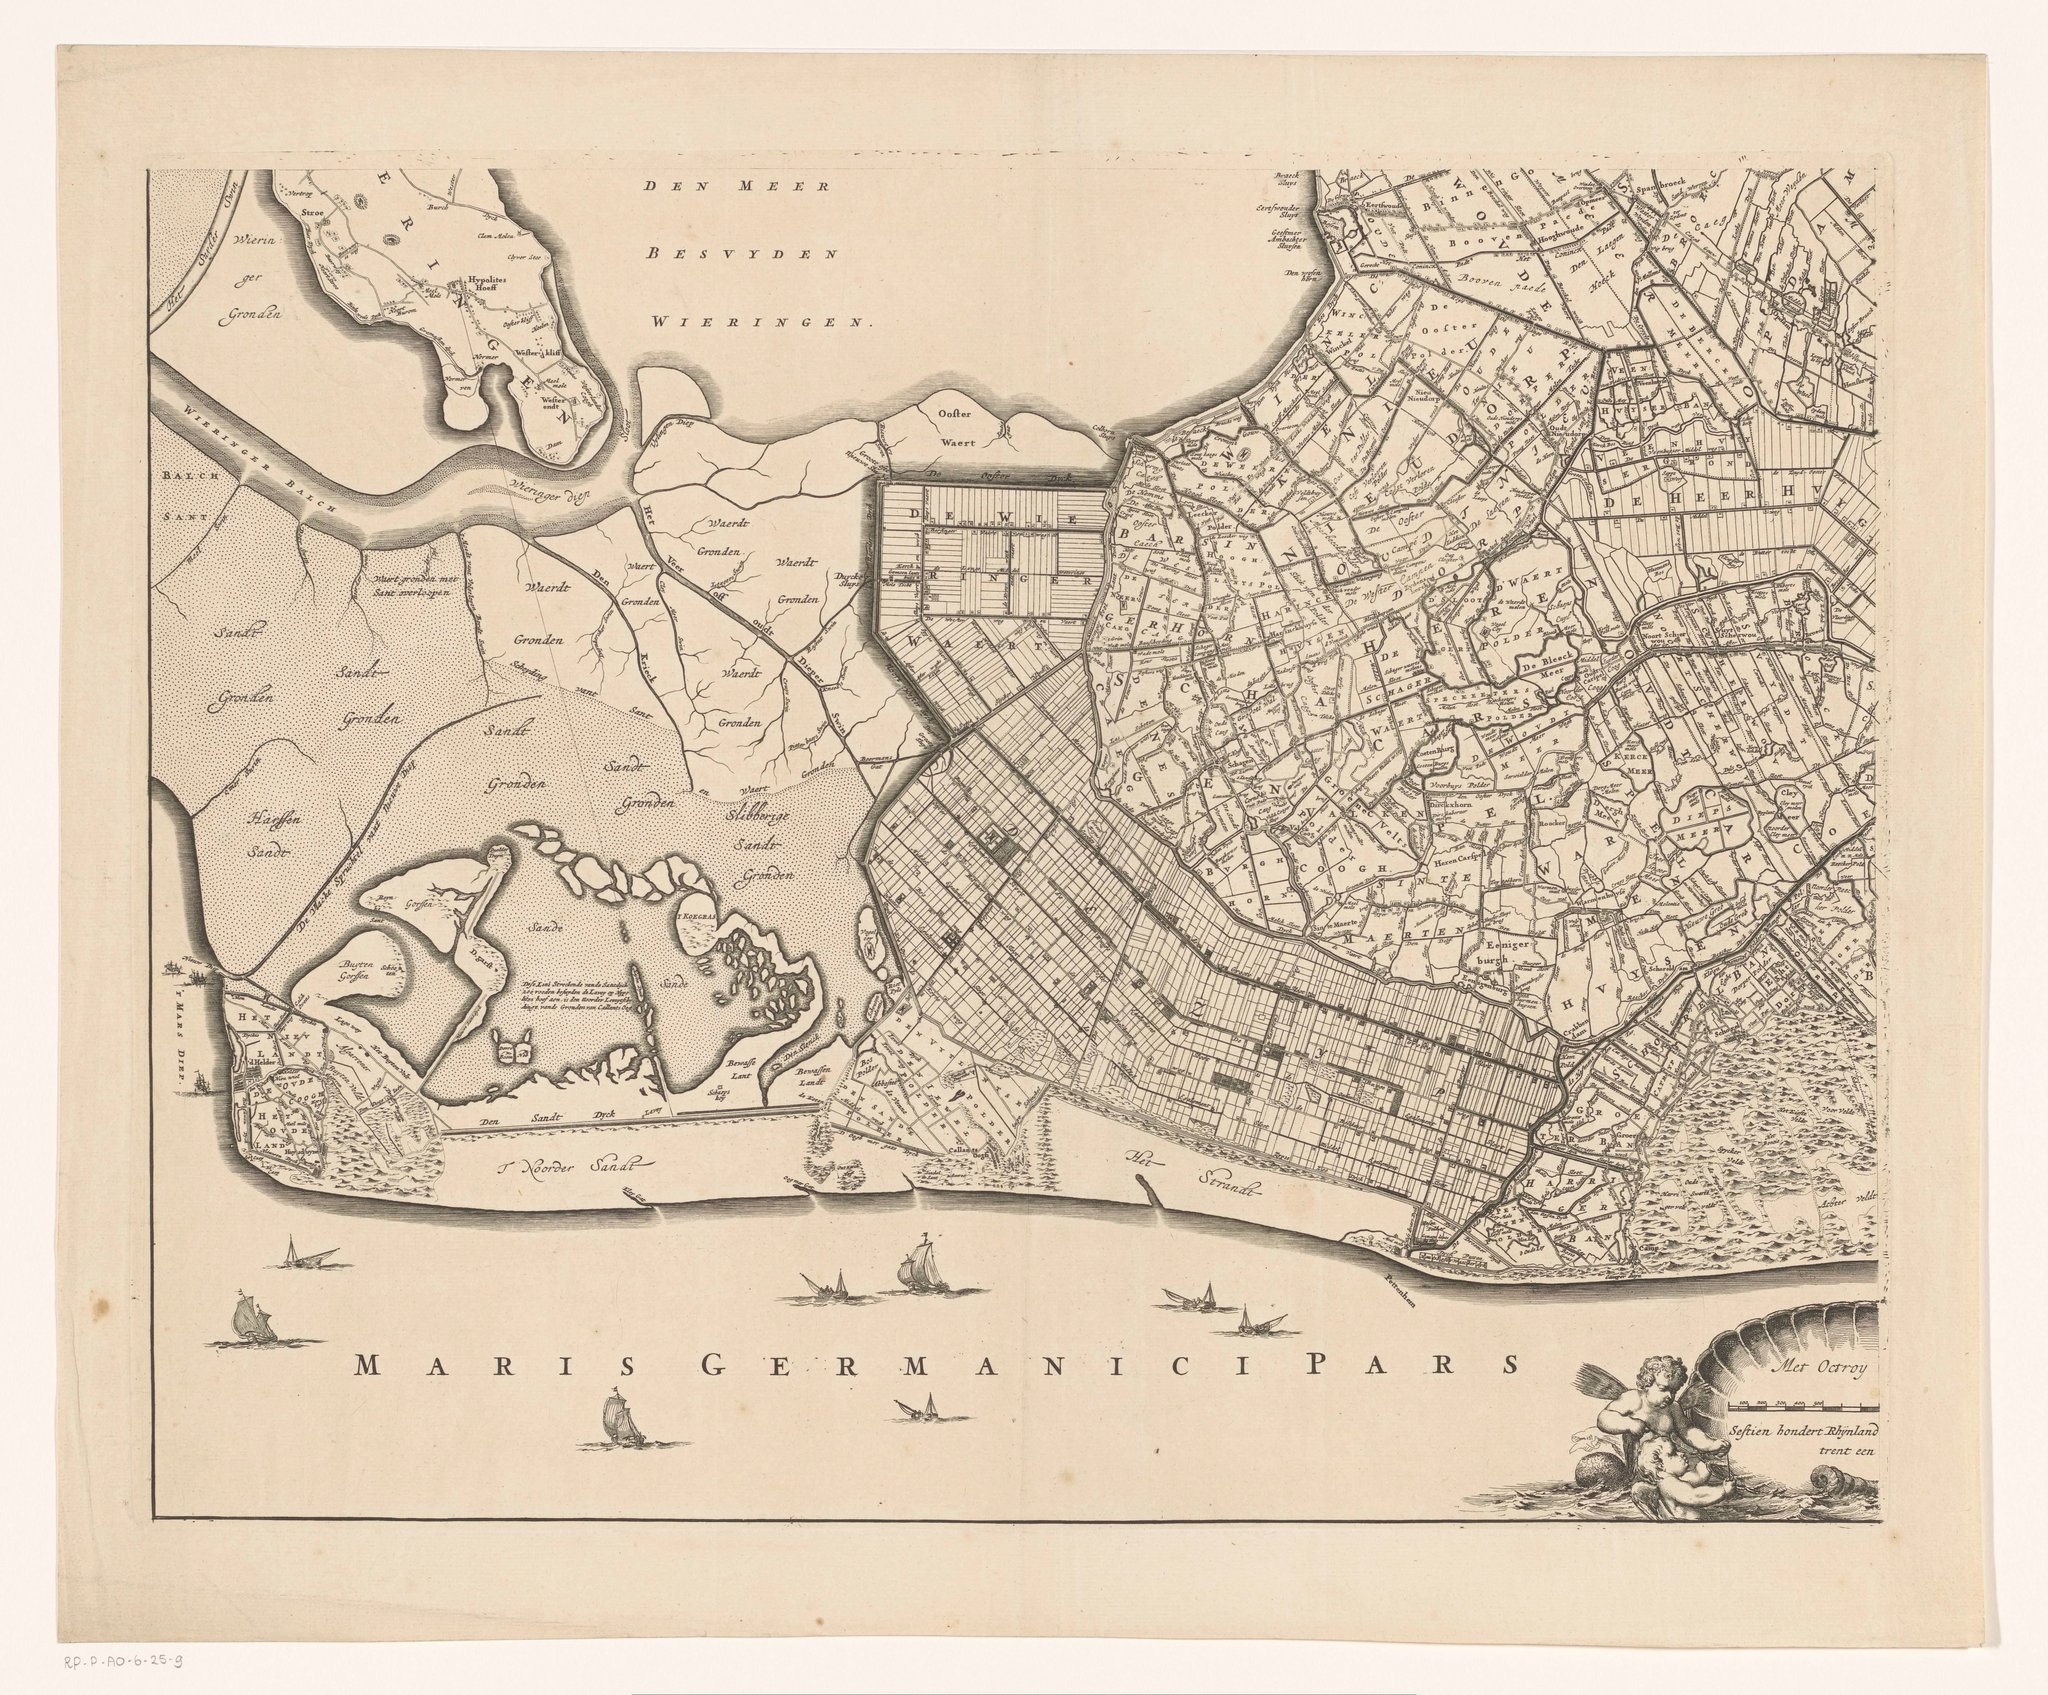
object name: map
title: 't Hoogh-heemraetschap vande Uytwaterende Sluysen in Kennemerlant ende West-Frieslant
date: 1734-1745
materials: paper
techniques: engraving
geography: amsterdam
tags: maps of separate countries or regions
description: In de collectie van het Rijksprentenkabinet bevinden zich verschillende exemplaren en staten van de vierdelige kaart waar dit blad (deel linksonder op de kaart) onderdeel van is. De kaarten zijn te dateren aan de hand van de namen van de dijkgraaf, hoogheemraden en rentmeester, te vinden op de twee bovenste bladen van de kaart. Omdat de twee onderste bladen door de jaren heen onveranderd zijn gebleven en niet duidelijk is welke losse onderste bladen bij welke bovenste horen, kunnen de onderste bladen niet precies gedateerd worden. Wel kan gesteld worden dat alle losse exemplaren van het blad dat het deel linksonder op de kaart vormt in de collectie óf bij de vierde staat uit 1734-1739, óf bij de vijfde staat uit 1745 horen.